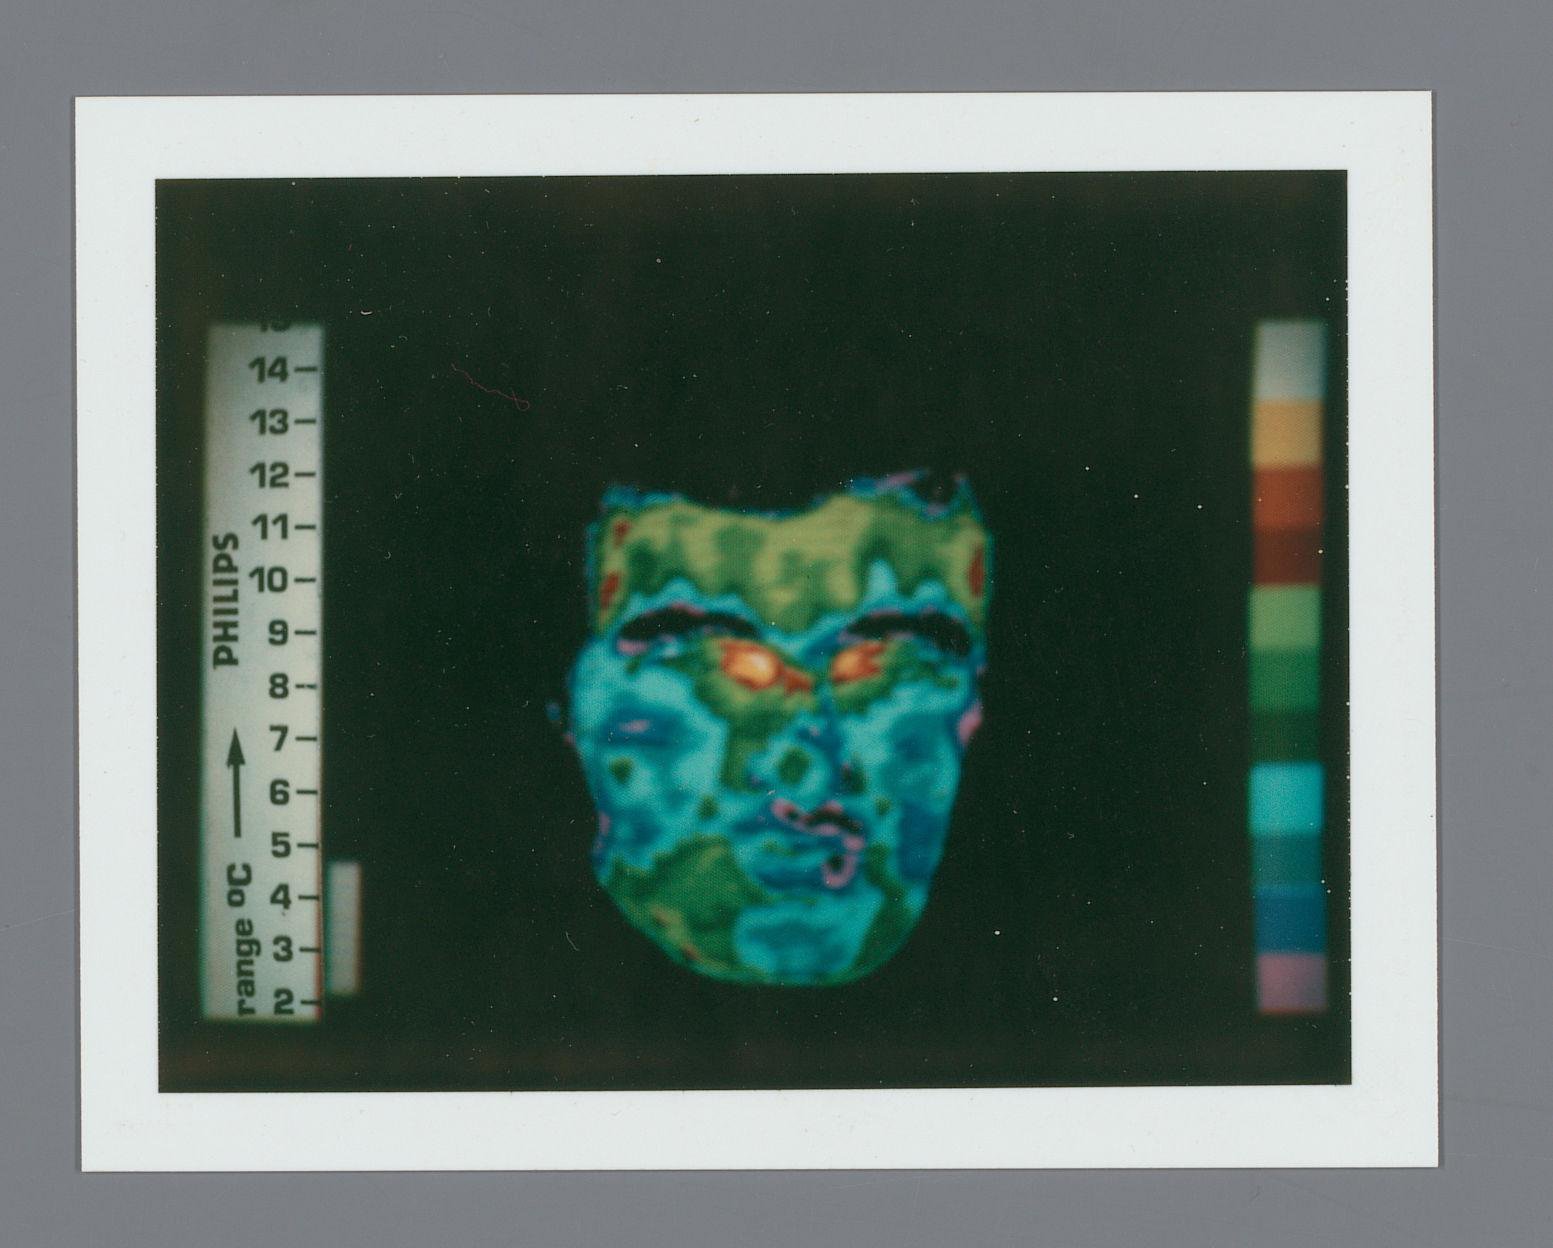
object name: instant photograph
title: Thermogram van een menselijk hoofd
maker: Anonymous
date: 1963-1984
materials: paper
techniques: peel apart (dye diffusion transfer print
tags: head (human)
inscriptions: number: ‘D85353PG’